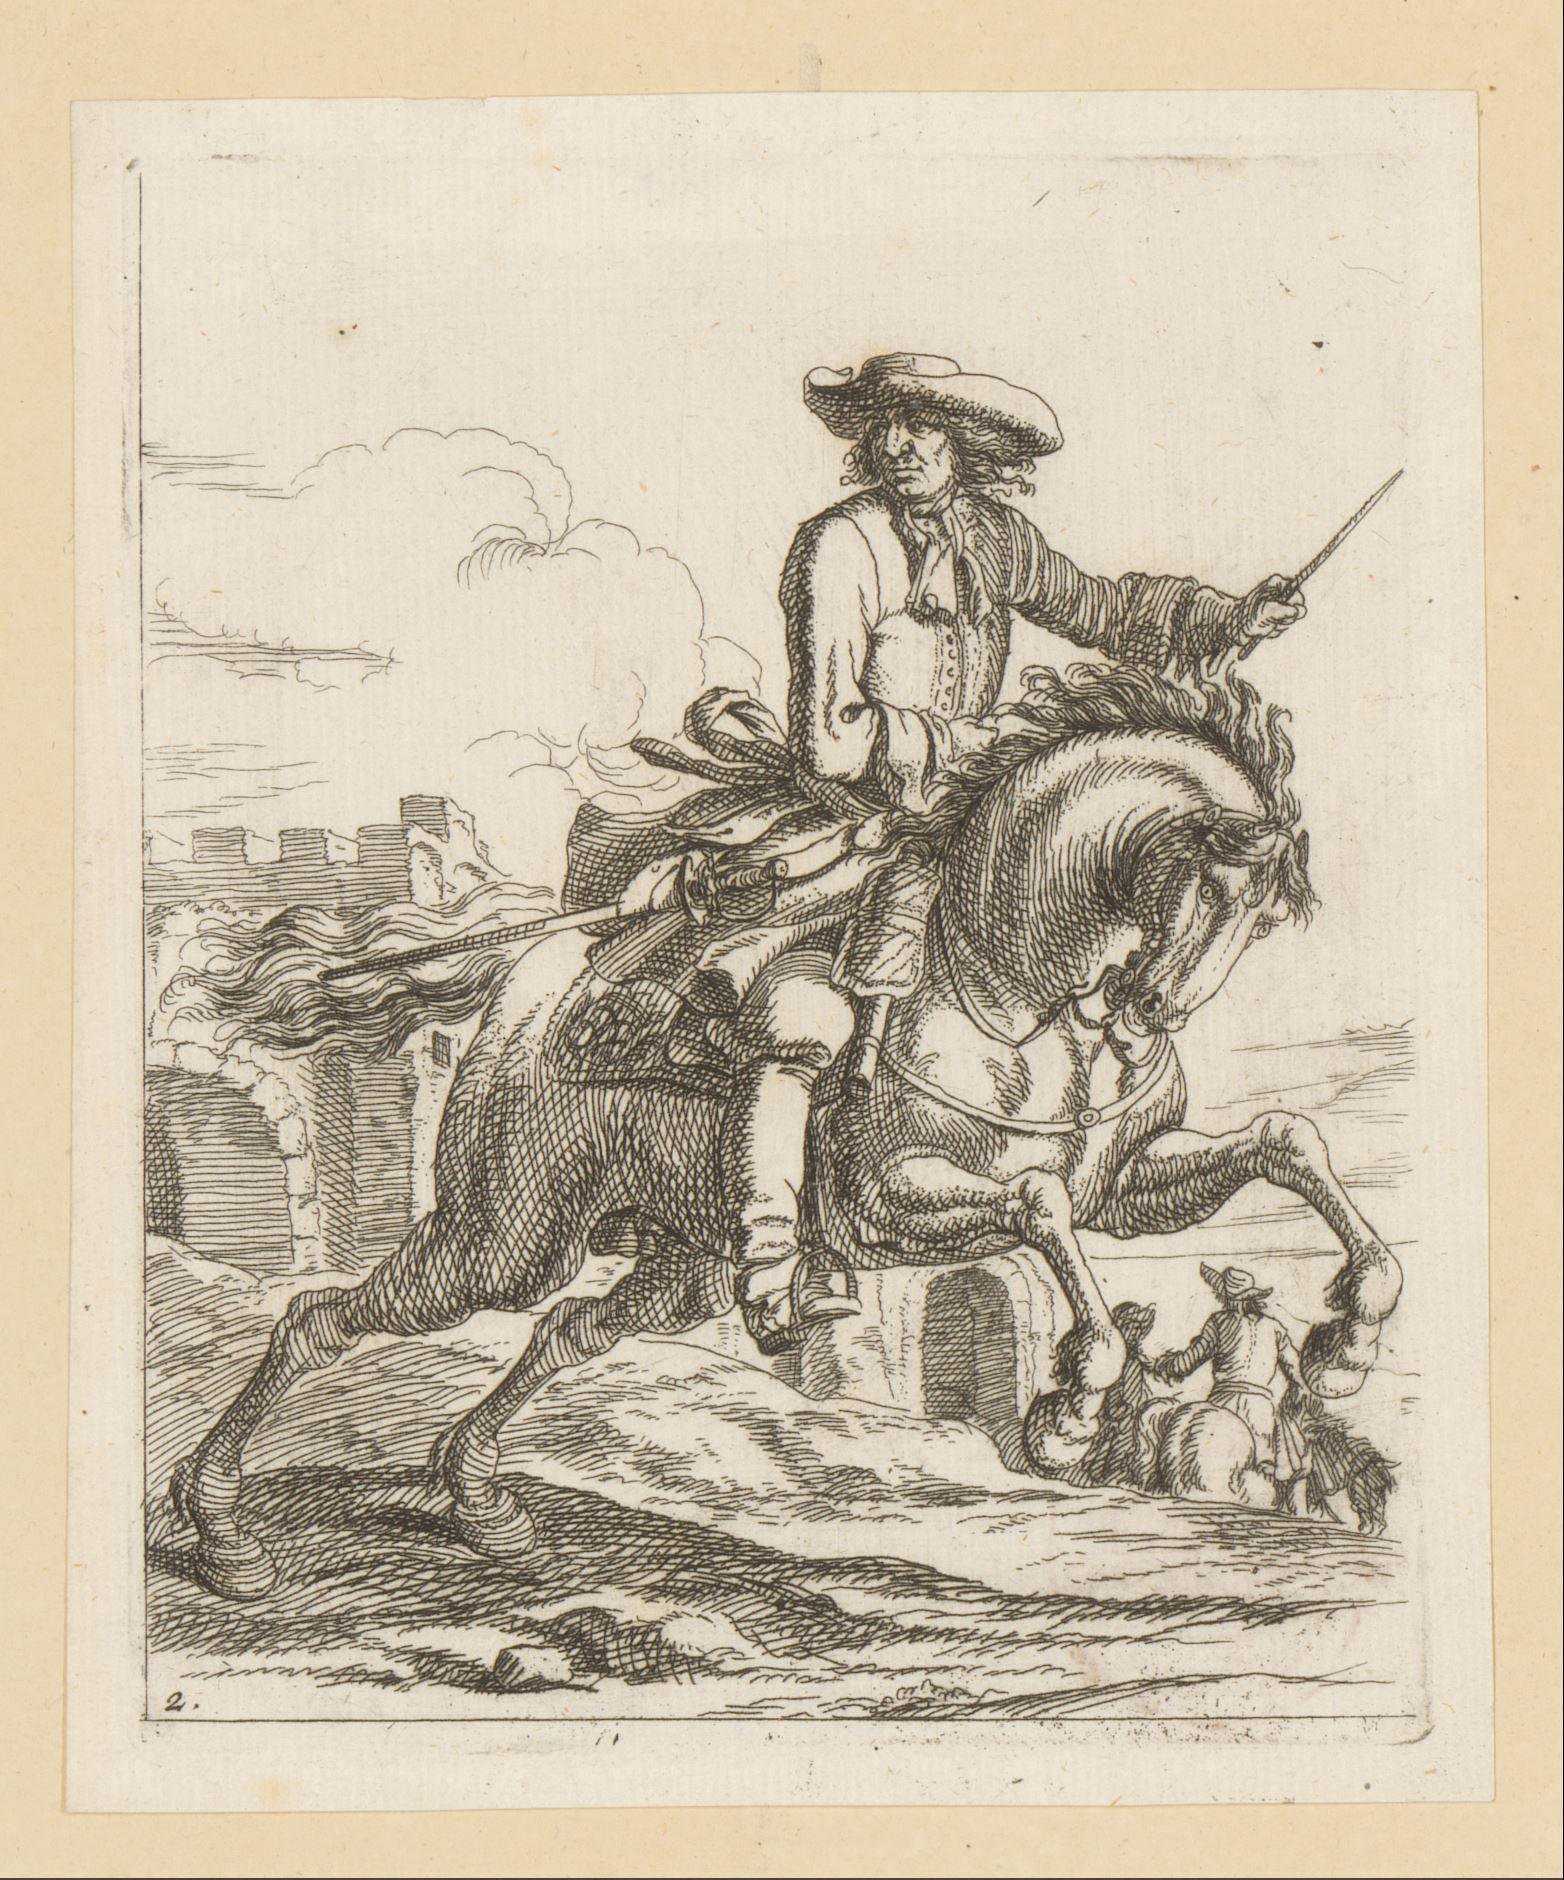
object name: print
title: Ruiters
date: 1676-1742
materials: paper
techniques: etching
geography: augsburg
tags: riding a horse, ass, or mule; rider, horseman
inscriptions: collector's mark: Lugt 240